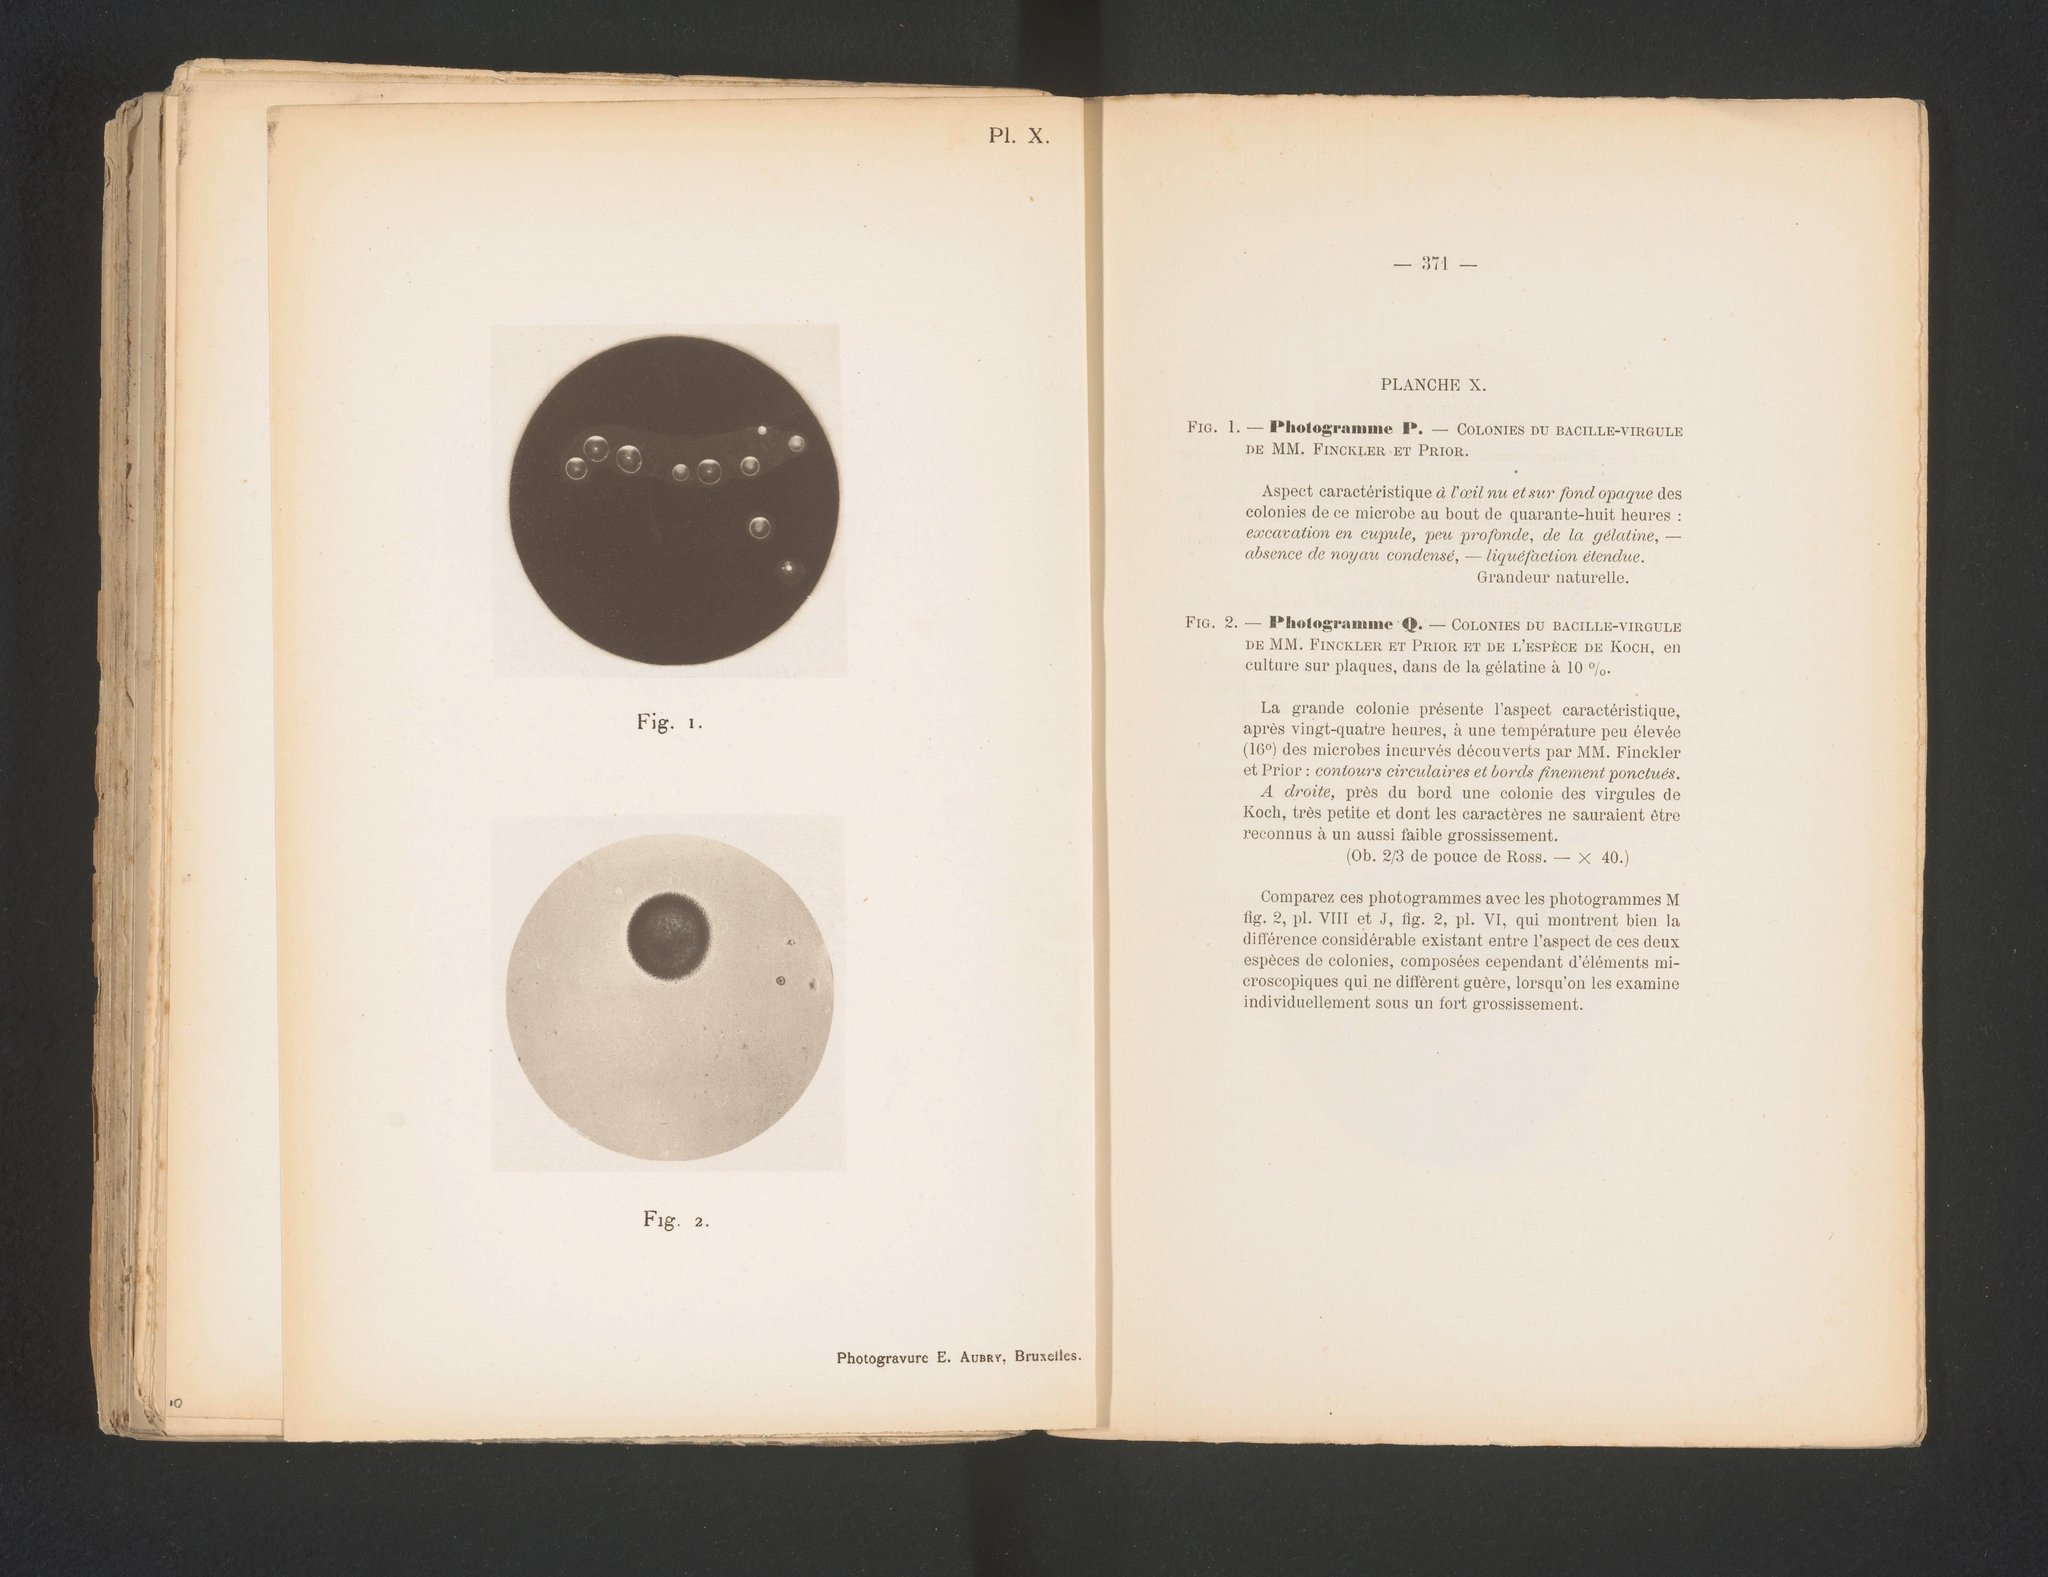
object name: page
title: Twee microscoopopnamen van cholera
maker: émile van ermengem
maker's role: bioloog, fotograaf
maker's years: 1851-1932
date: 1875-1885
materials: paper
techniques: photograph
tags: diseases affecting the whole body, microscope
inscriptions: number: ‘Pl. X. Fig. 1. Fig. 2.’, inscription: ‘Fig. 1.- Photogramme P. Colonies du bacille-virgule de Mm. Finckler et Prior (...) Fig. 2. - Photogramme Q.- Colonies du bacilles-virgules de Mm. Finckler et Prior et de l'espèce de Koch, en culture sur plaques, dans de la gélatine à 10 % (...)’